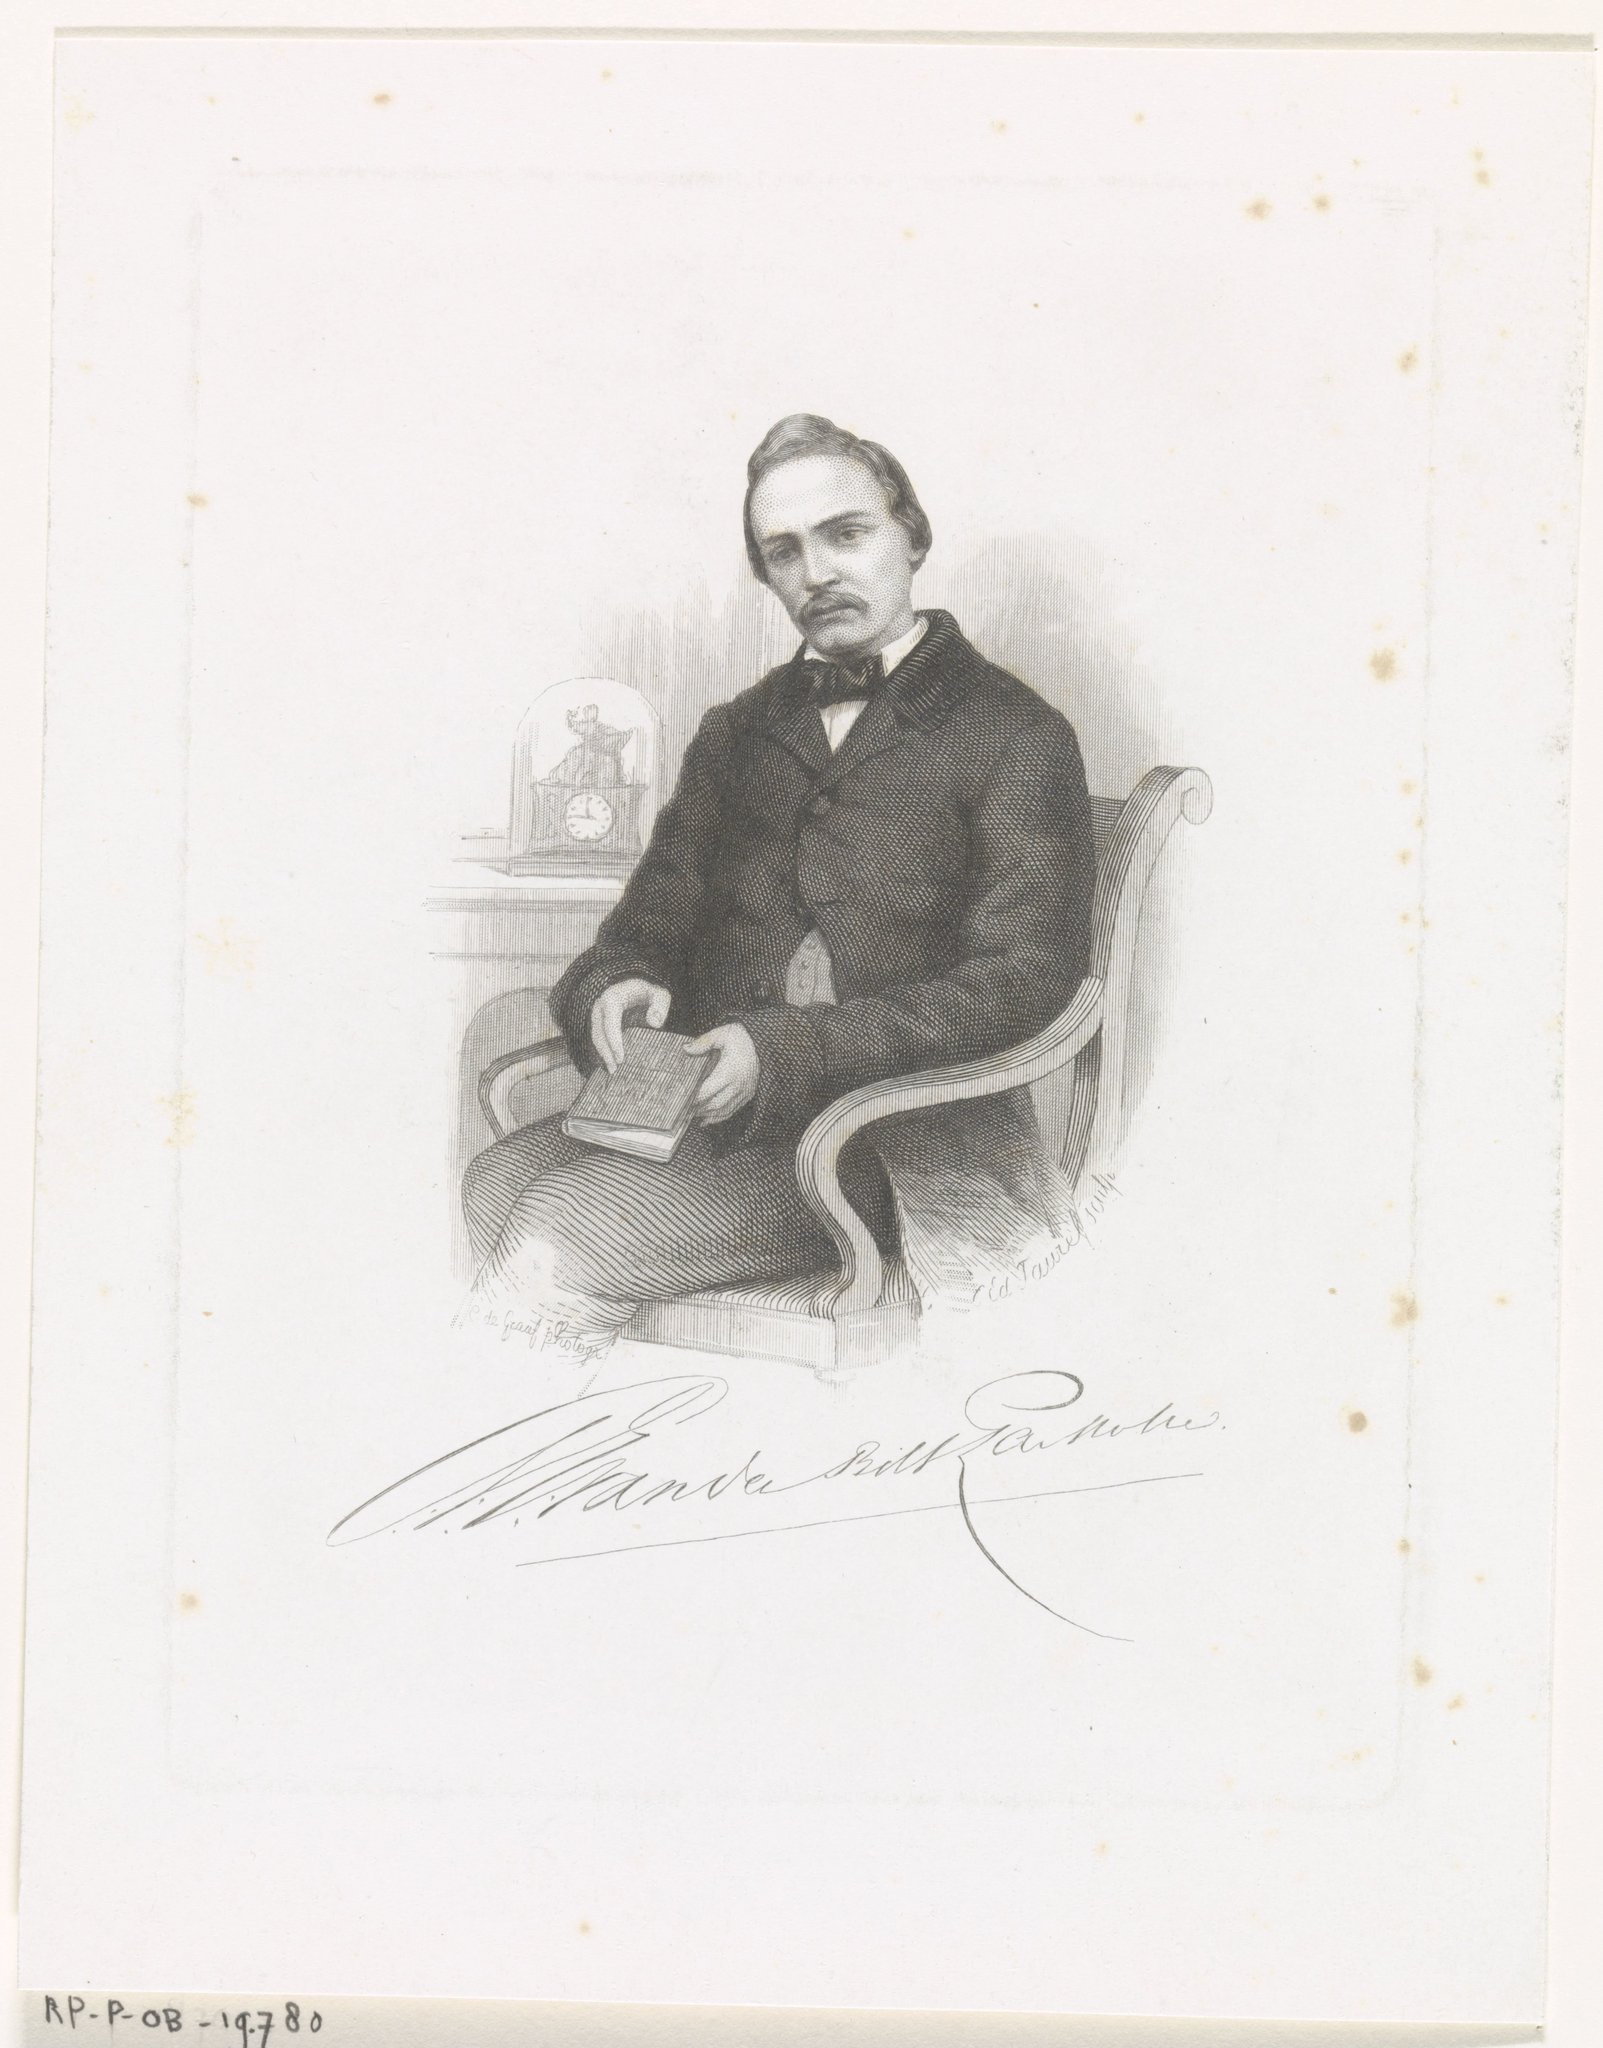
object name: print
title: Portret van een onbekende man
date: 1834-1892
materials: paper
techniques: etching, roulette, engraving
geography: amsterdam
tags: book, chair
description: Portret van een onbekende man, op een stoel met een boek in zijn handen.